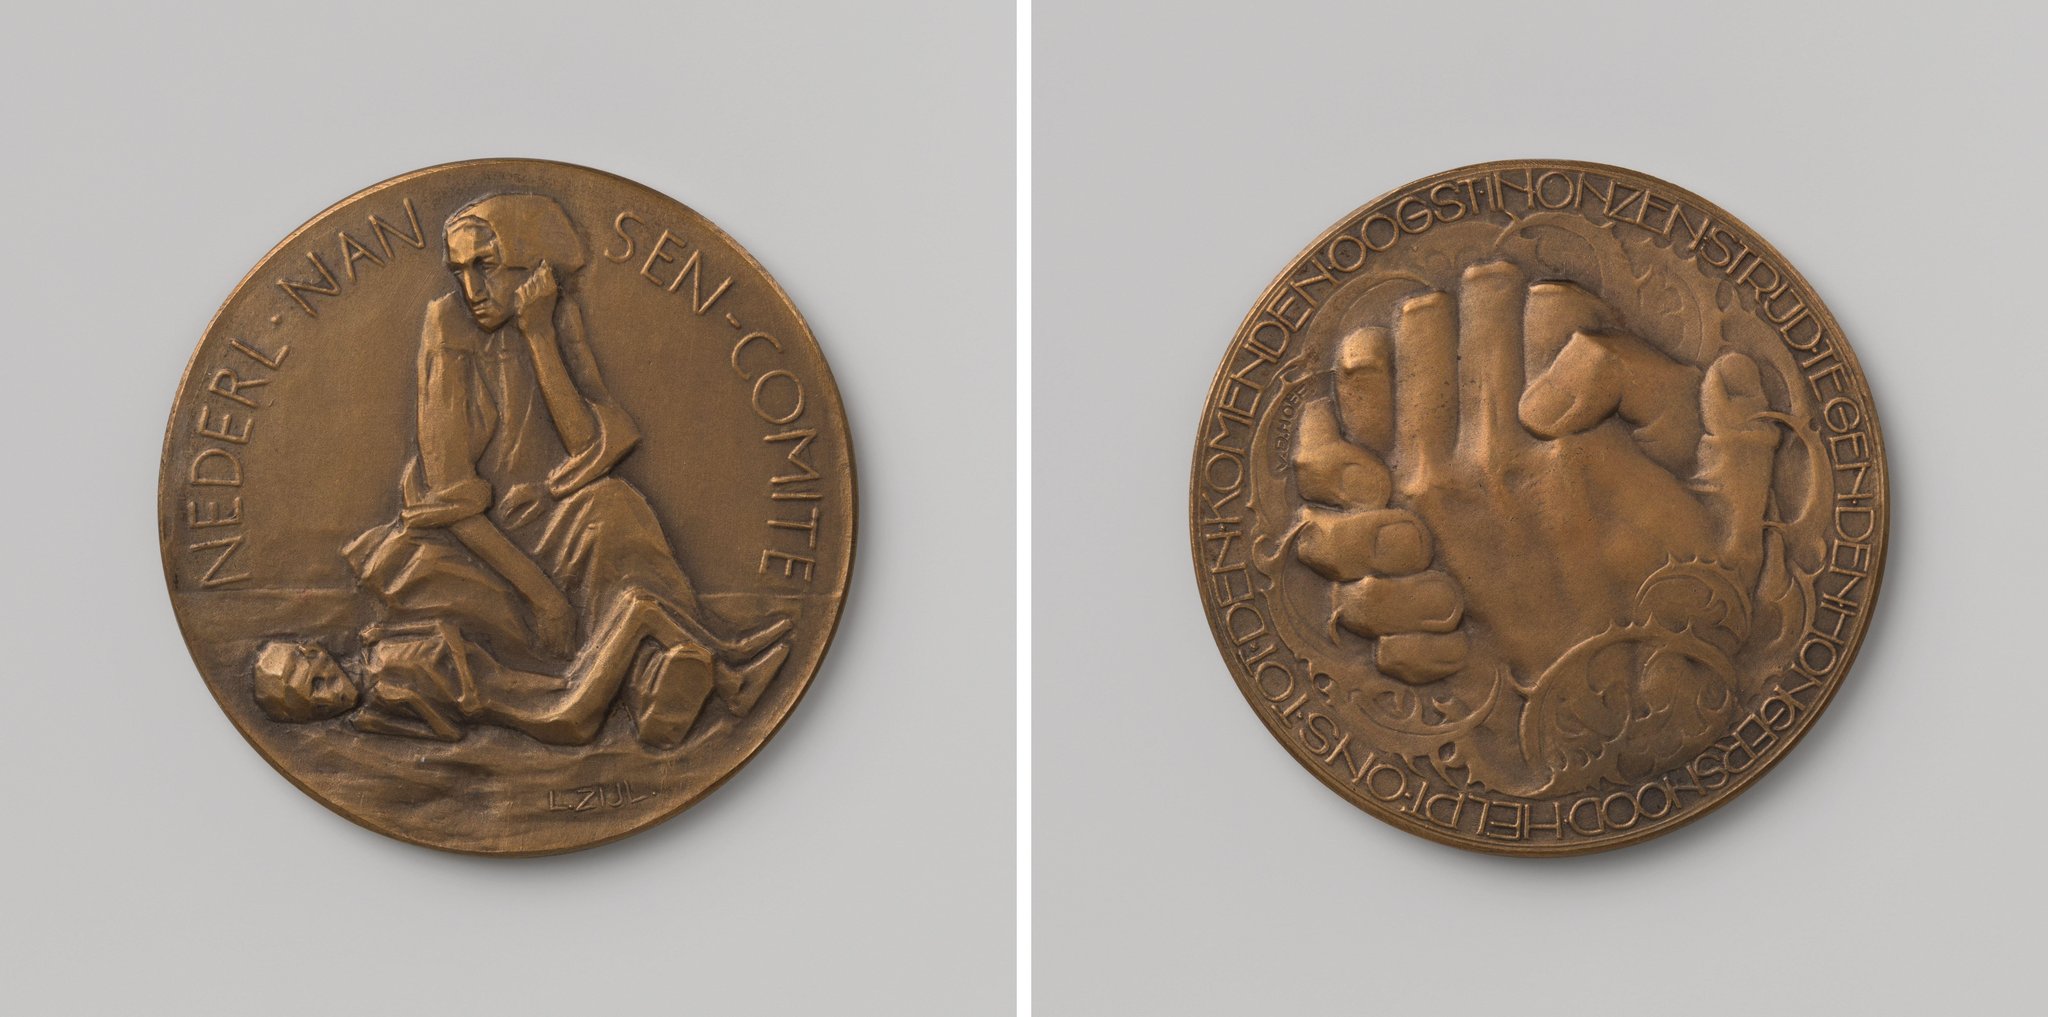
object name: history medal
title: Nederlandsch Nansencomite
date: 1923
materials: bronze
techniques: striking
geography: voorschoten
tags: nederlands nansen-comité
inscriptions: inscription: ‘NEDERL.NANSEN-COMITE’, circumscription: ‘HELPT . ONS . TOT . DEN . KOMENDEN . OOGST IN ONZEN STRIJD . TEGEN . DEN . HONGERSNOOD .’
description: Bronzen penning. Steunpenning van het Nederlands Nansen-comité tegen hongersnood in Rusland. Voorzijde: treurende vrouw, zittend bij lijk van uitgemergeld kind binnen omschrift. Keerzijde: twee samengevouwen handen, omgeven door doornentakken binnen omschrift.